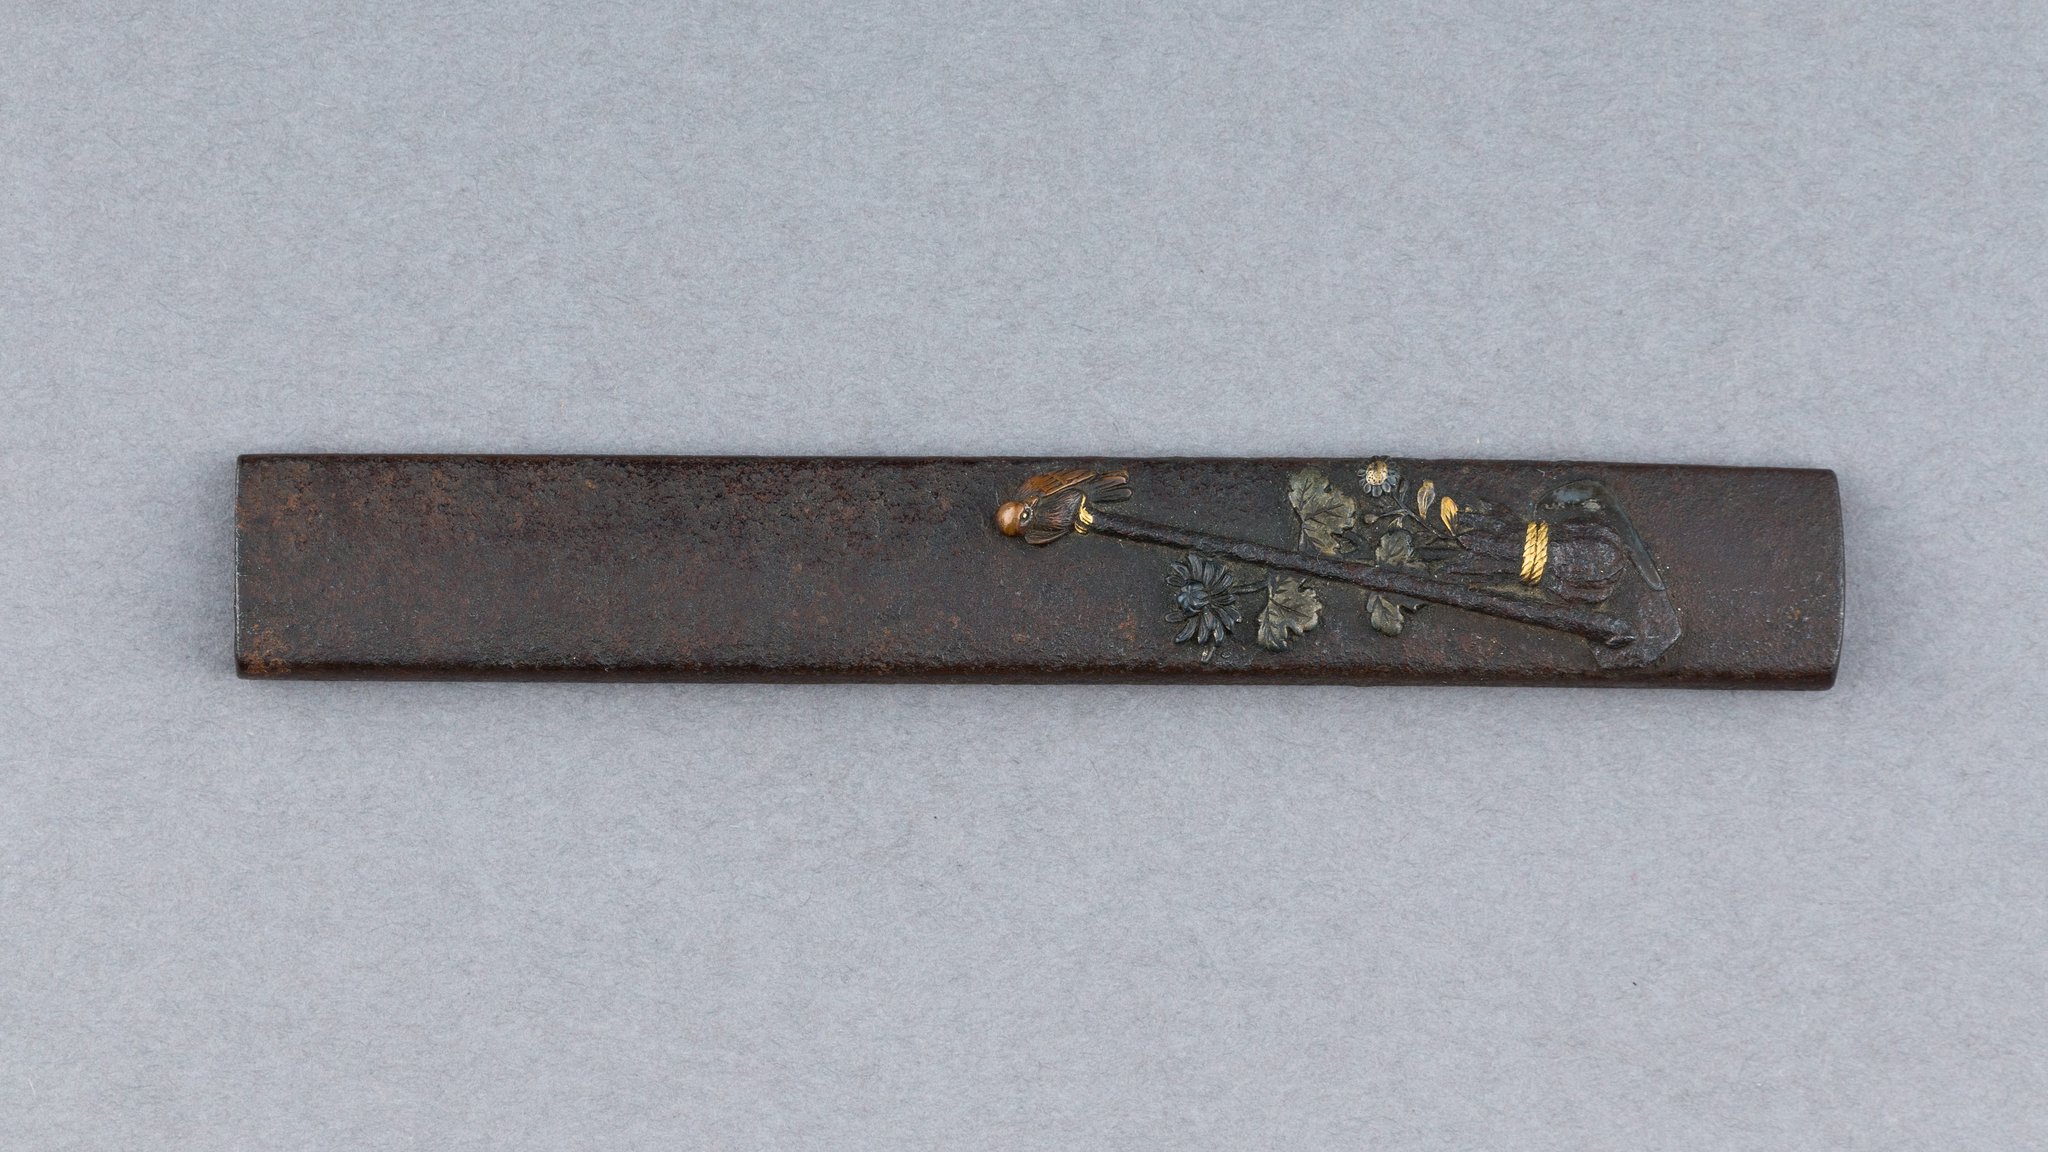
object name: knife handle kozuka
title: Knife Handle (Kozuka)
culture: japanese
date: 1615-1868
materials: copper, gold, iron, silver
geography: japan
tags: birds,flowers